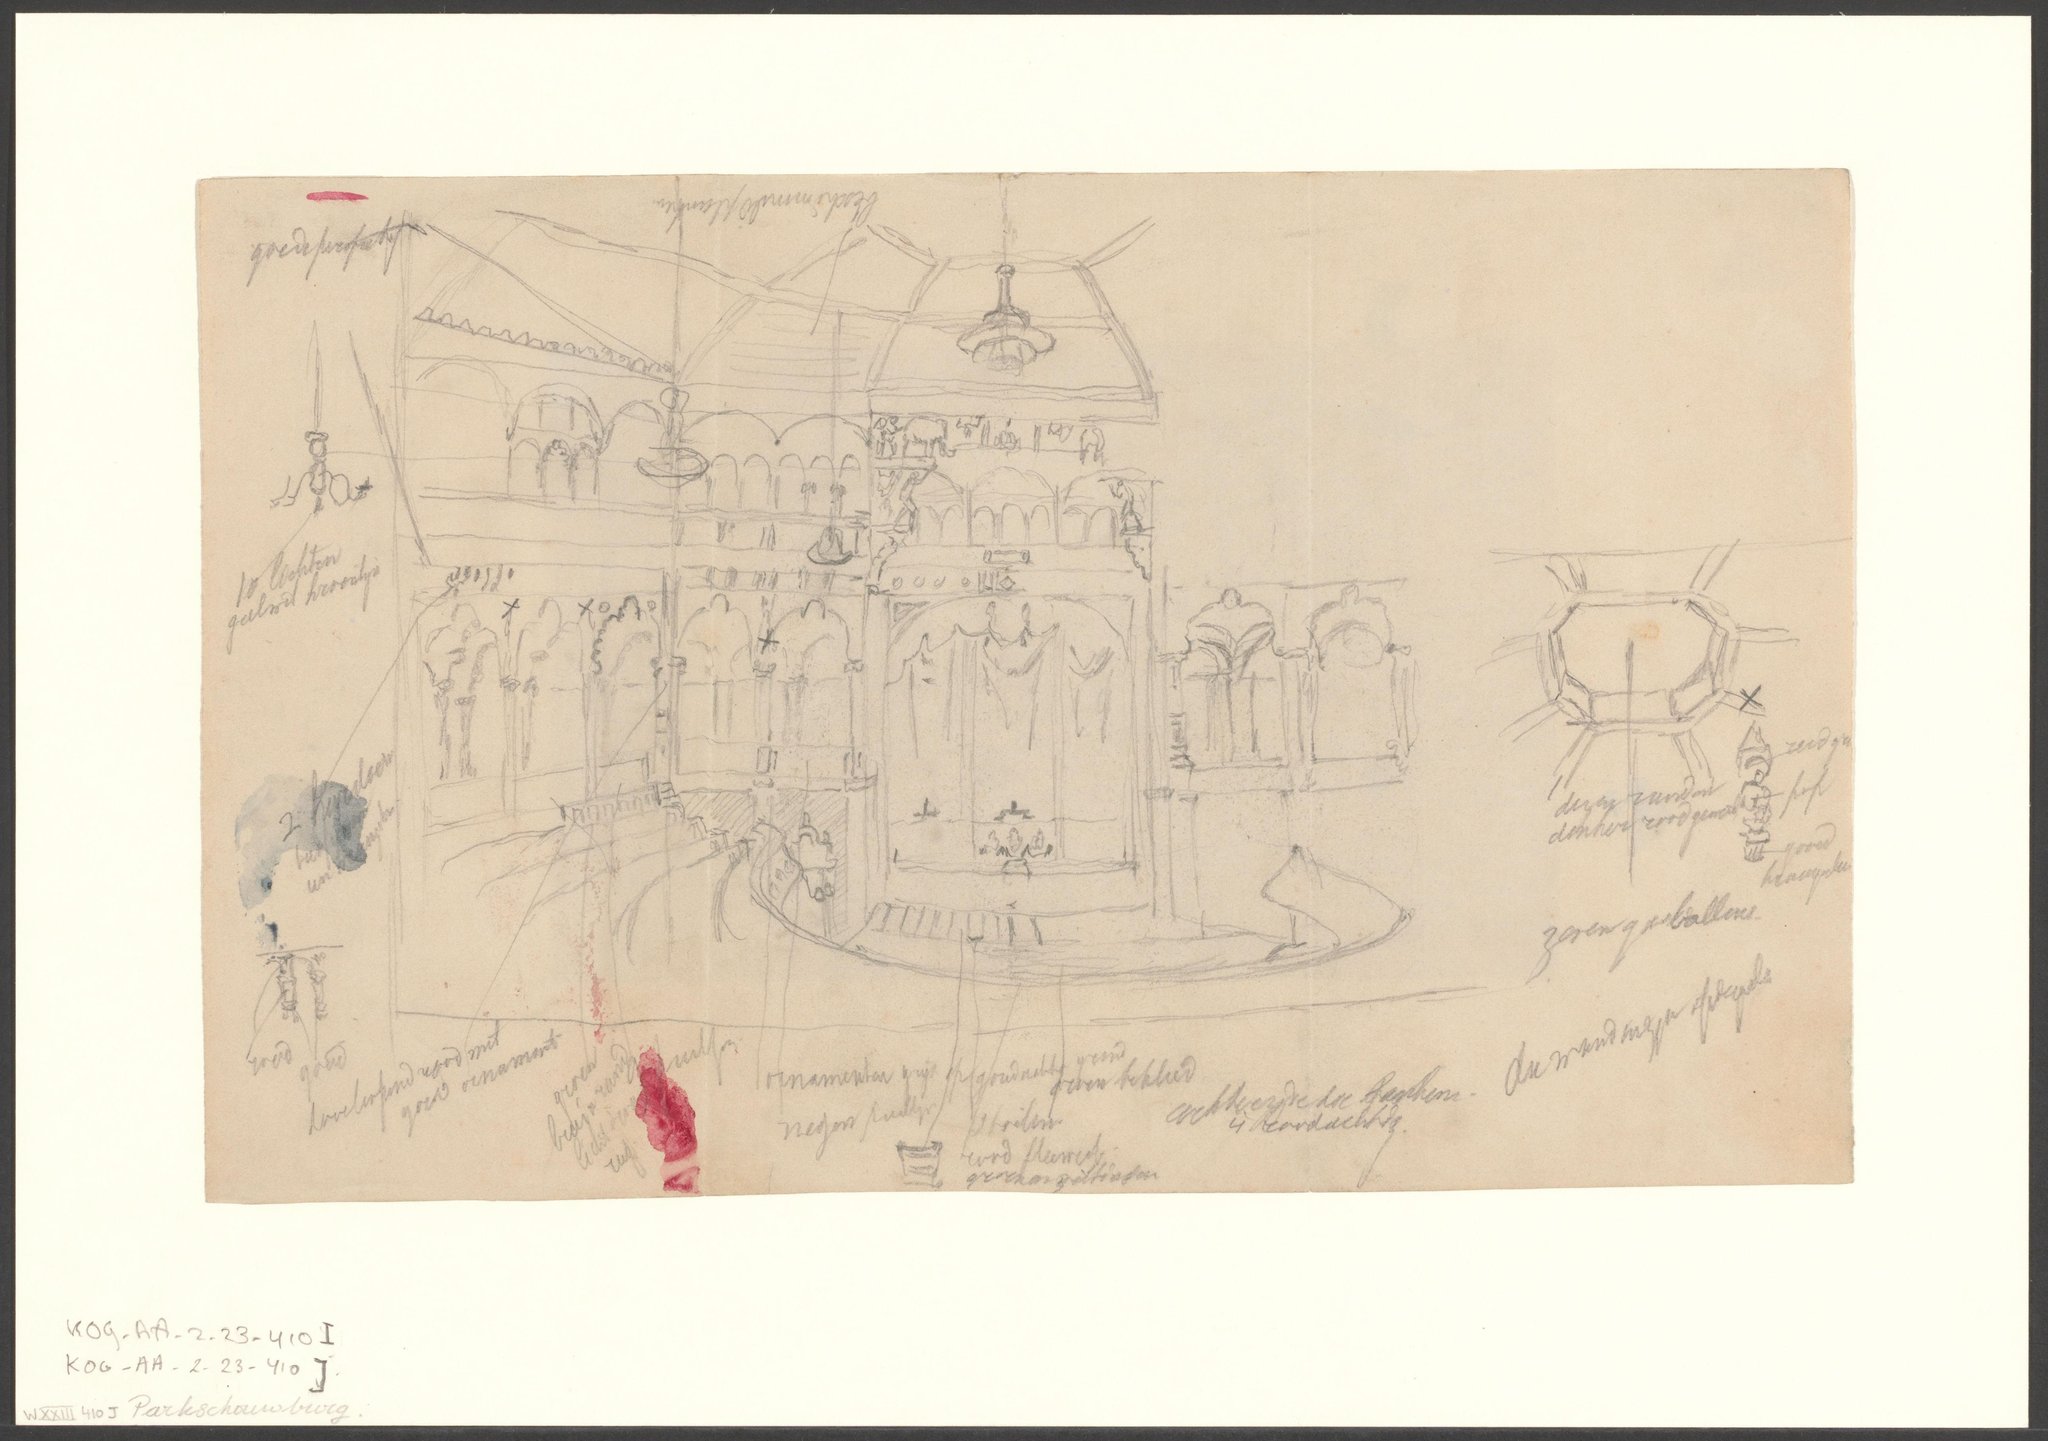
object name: drawing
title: Interieur van de Parkschouwburg gezien naar het toneel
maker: johan george lodewijk rieke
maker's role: draughtsman, print maker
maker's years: 1817-1898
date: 1883-1898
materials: paper, pencil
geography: amsterdam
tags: theatre, theatrical performance, the stage and its equipment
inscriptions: inscription: ‘in de [...]e[...]en (...) hout 9 stoelen’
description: Tekening binnen de Atlas Van Eck ingedeeld op wijknummer 23.